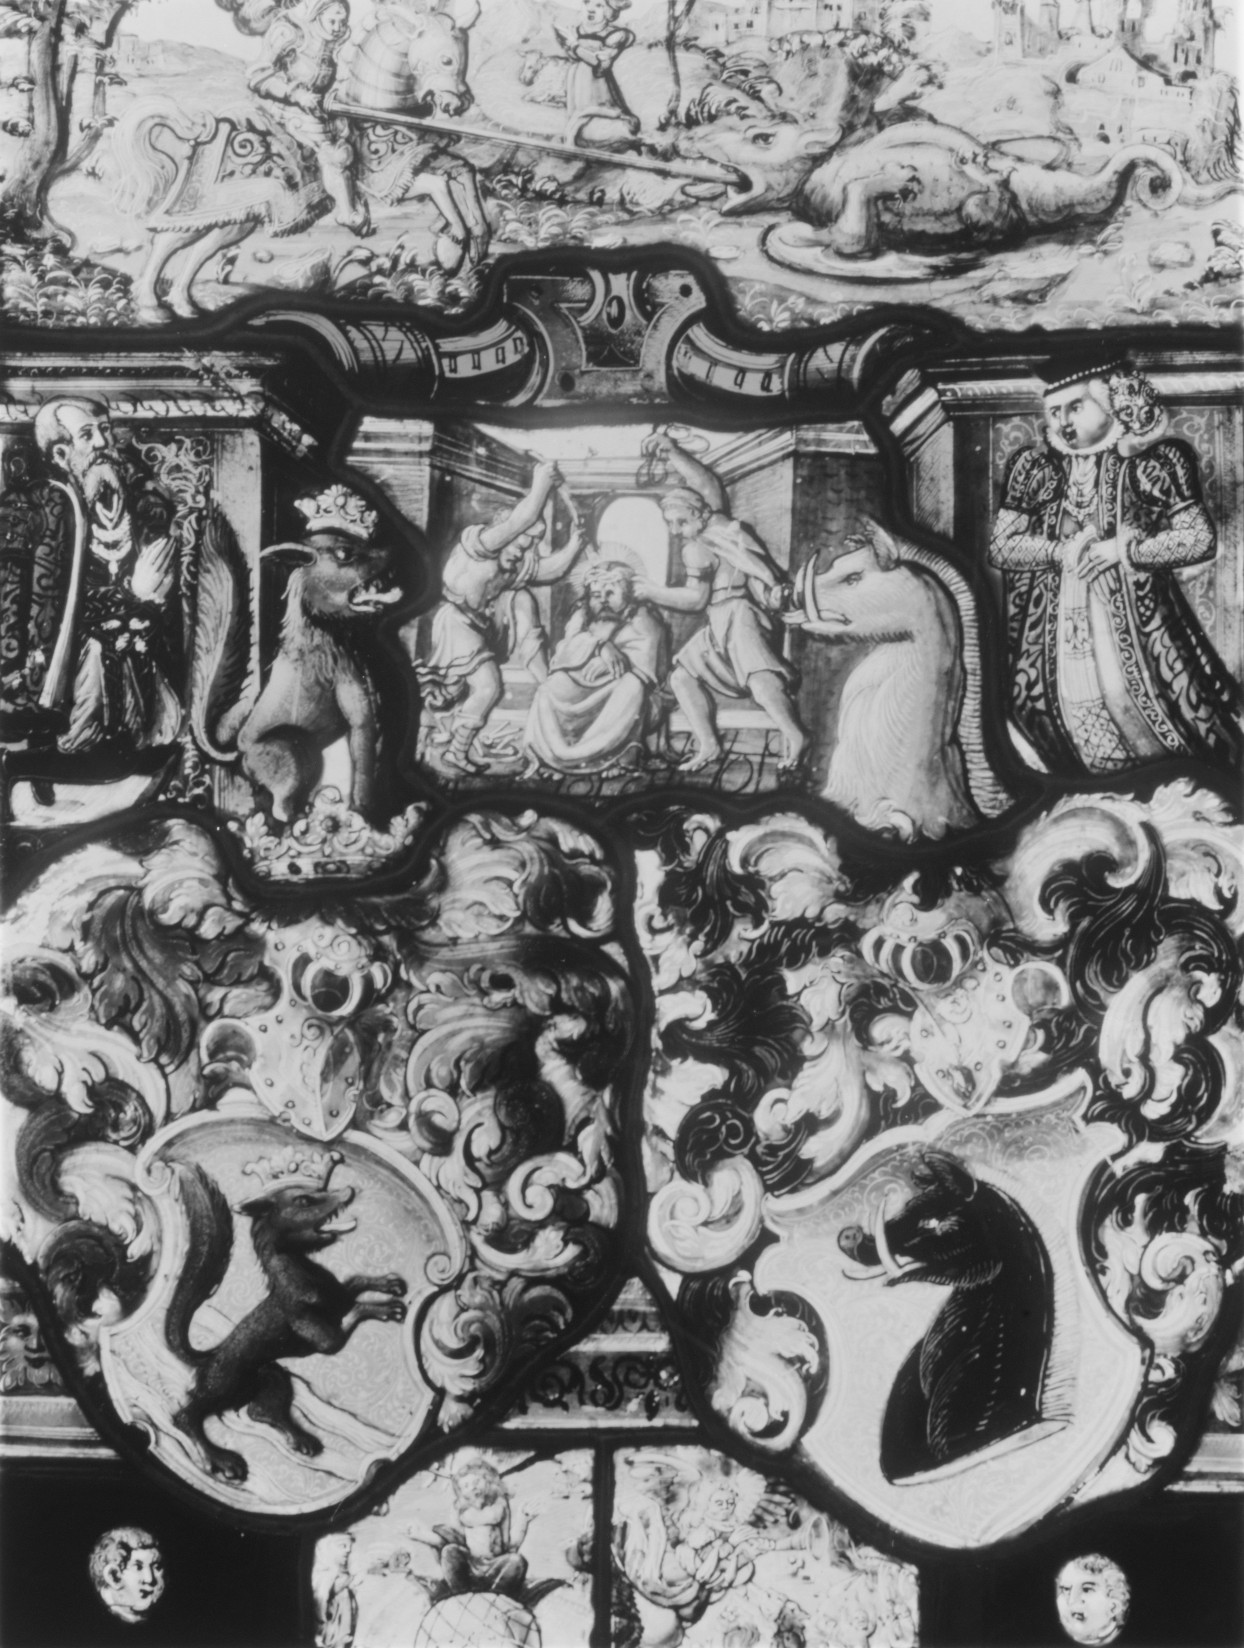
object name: panel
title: Saint George and the Dragon, the Scourging of Christ and the Last Judgement, with donor figures and armorials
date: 1567-1600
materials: glass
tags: animals,men,horses,saint george